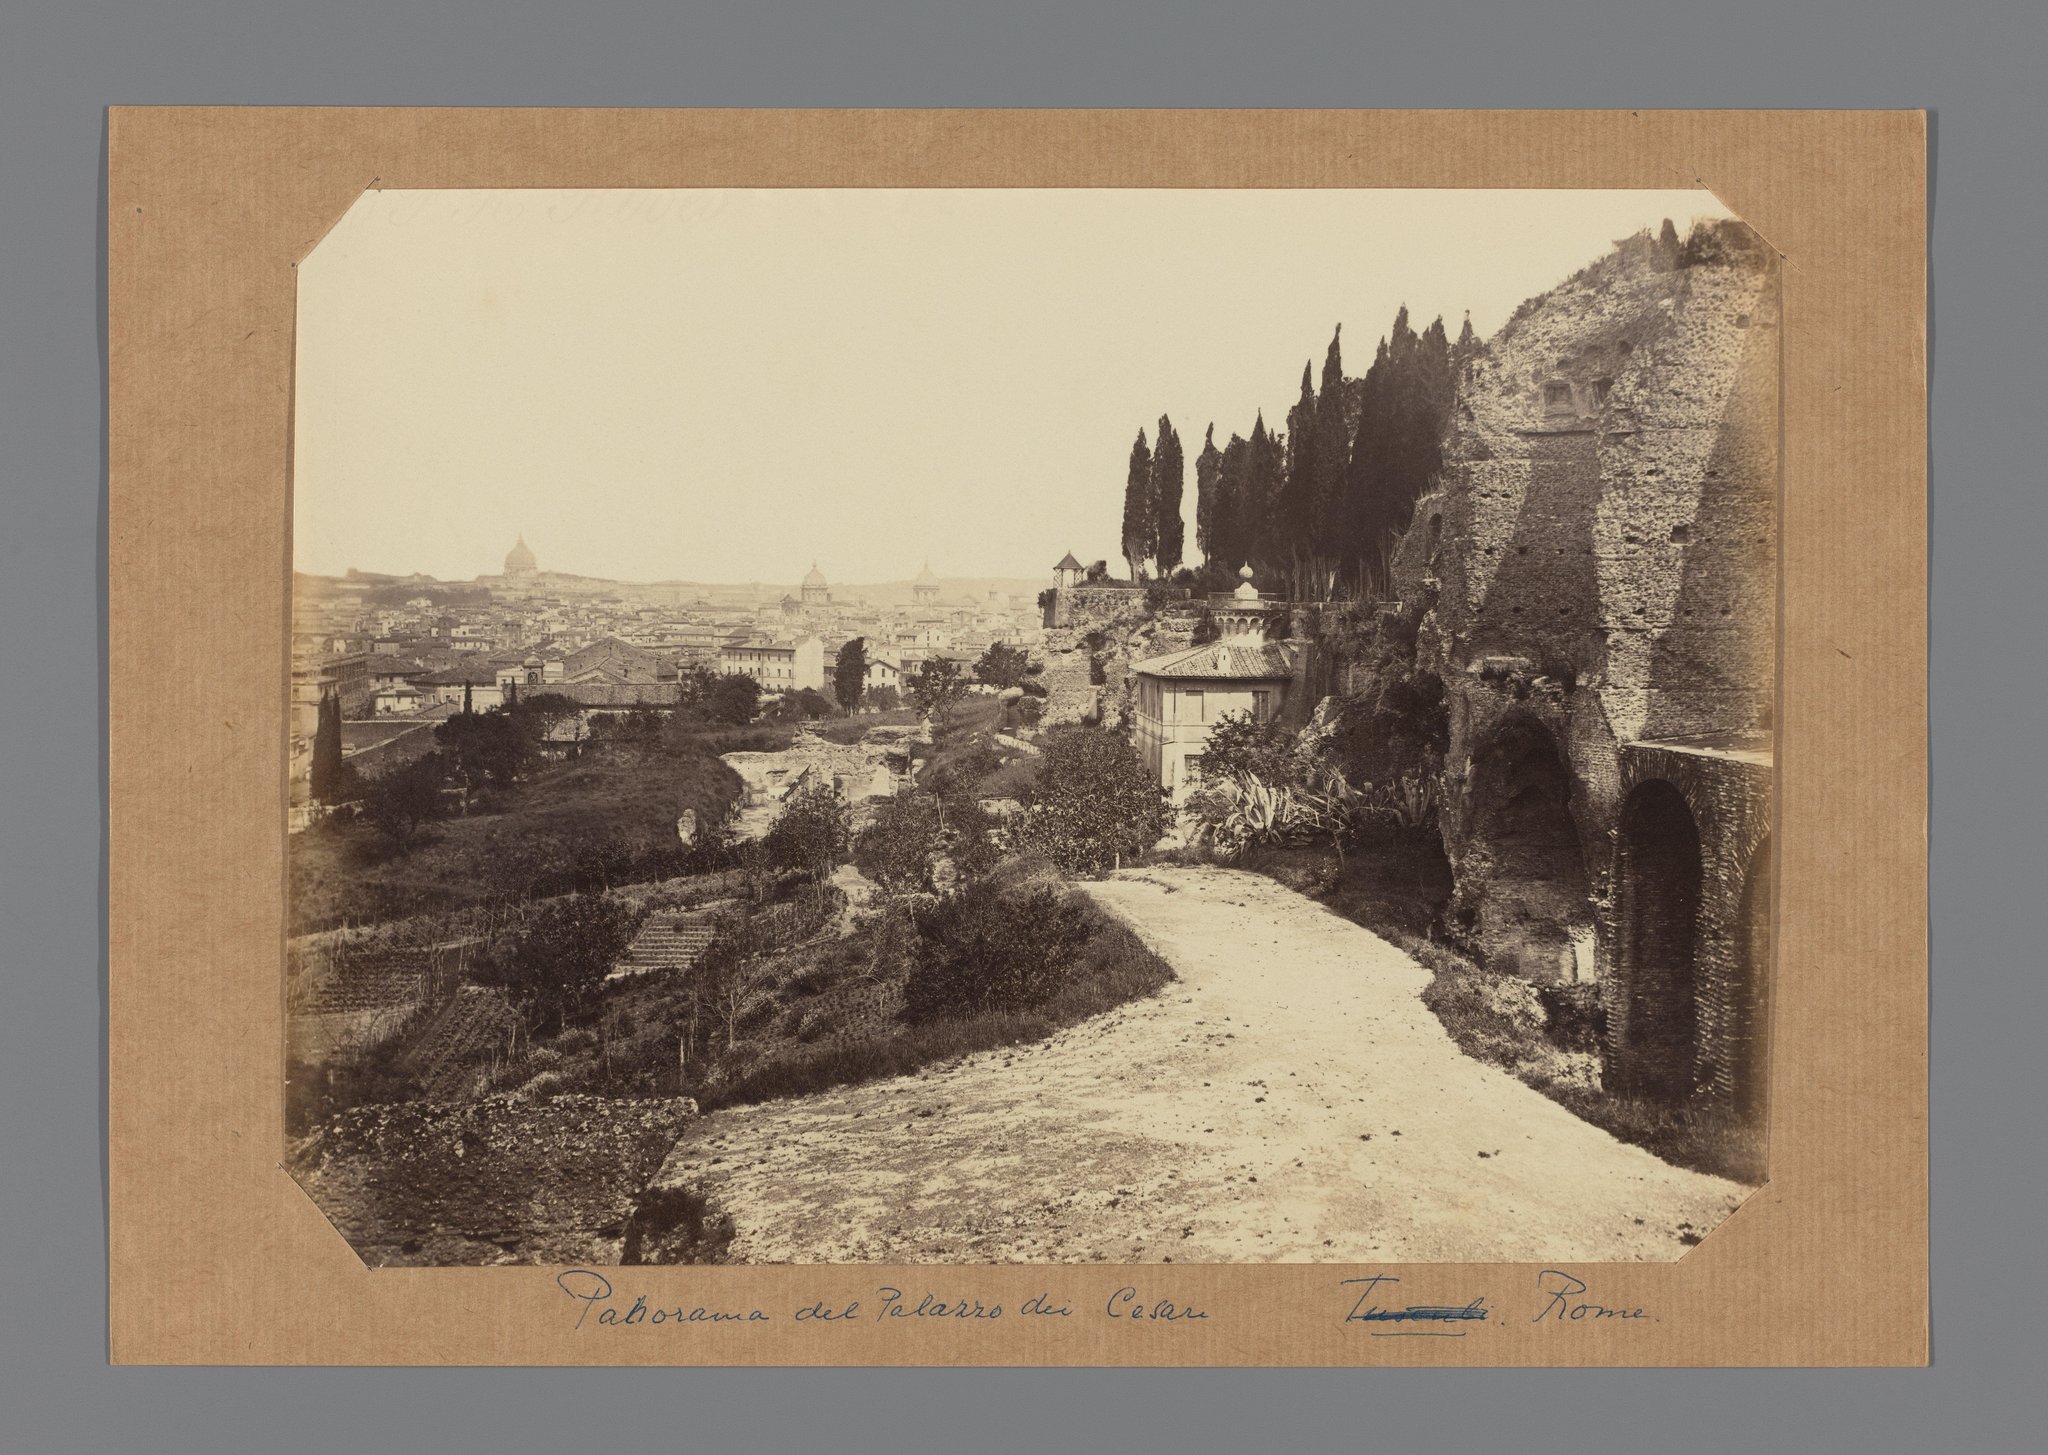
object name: photograph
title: Italië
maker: Anonymous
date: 1880-1910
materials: photographic support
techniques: albumen print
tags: italy